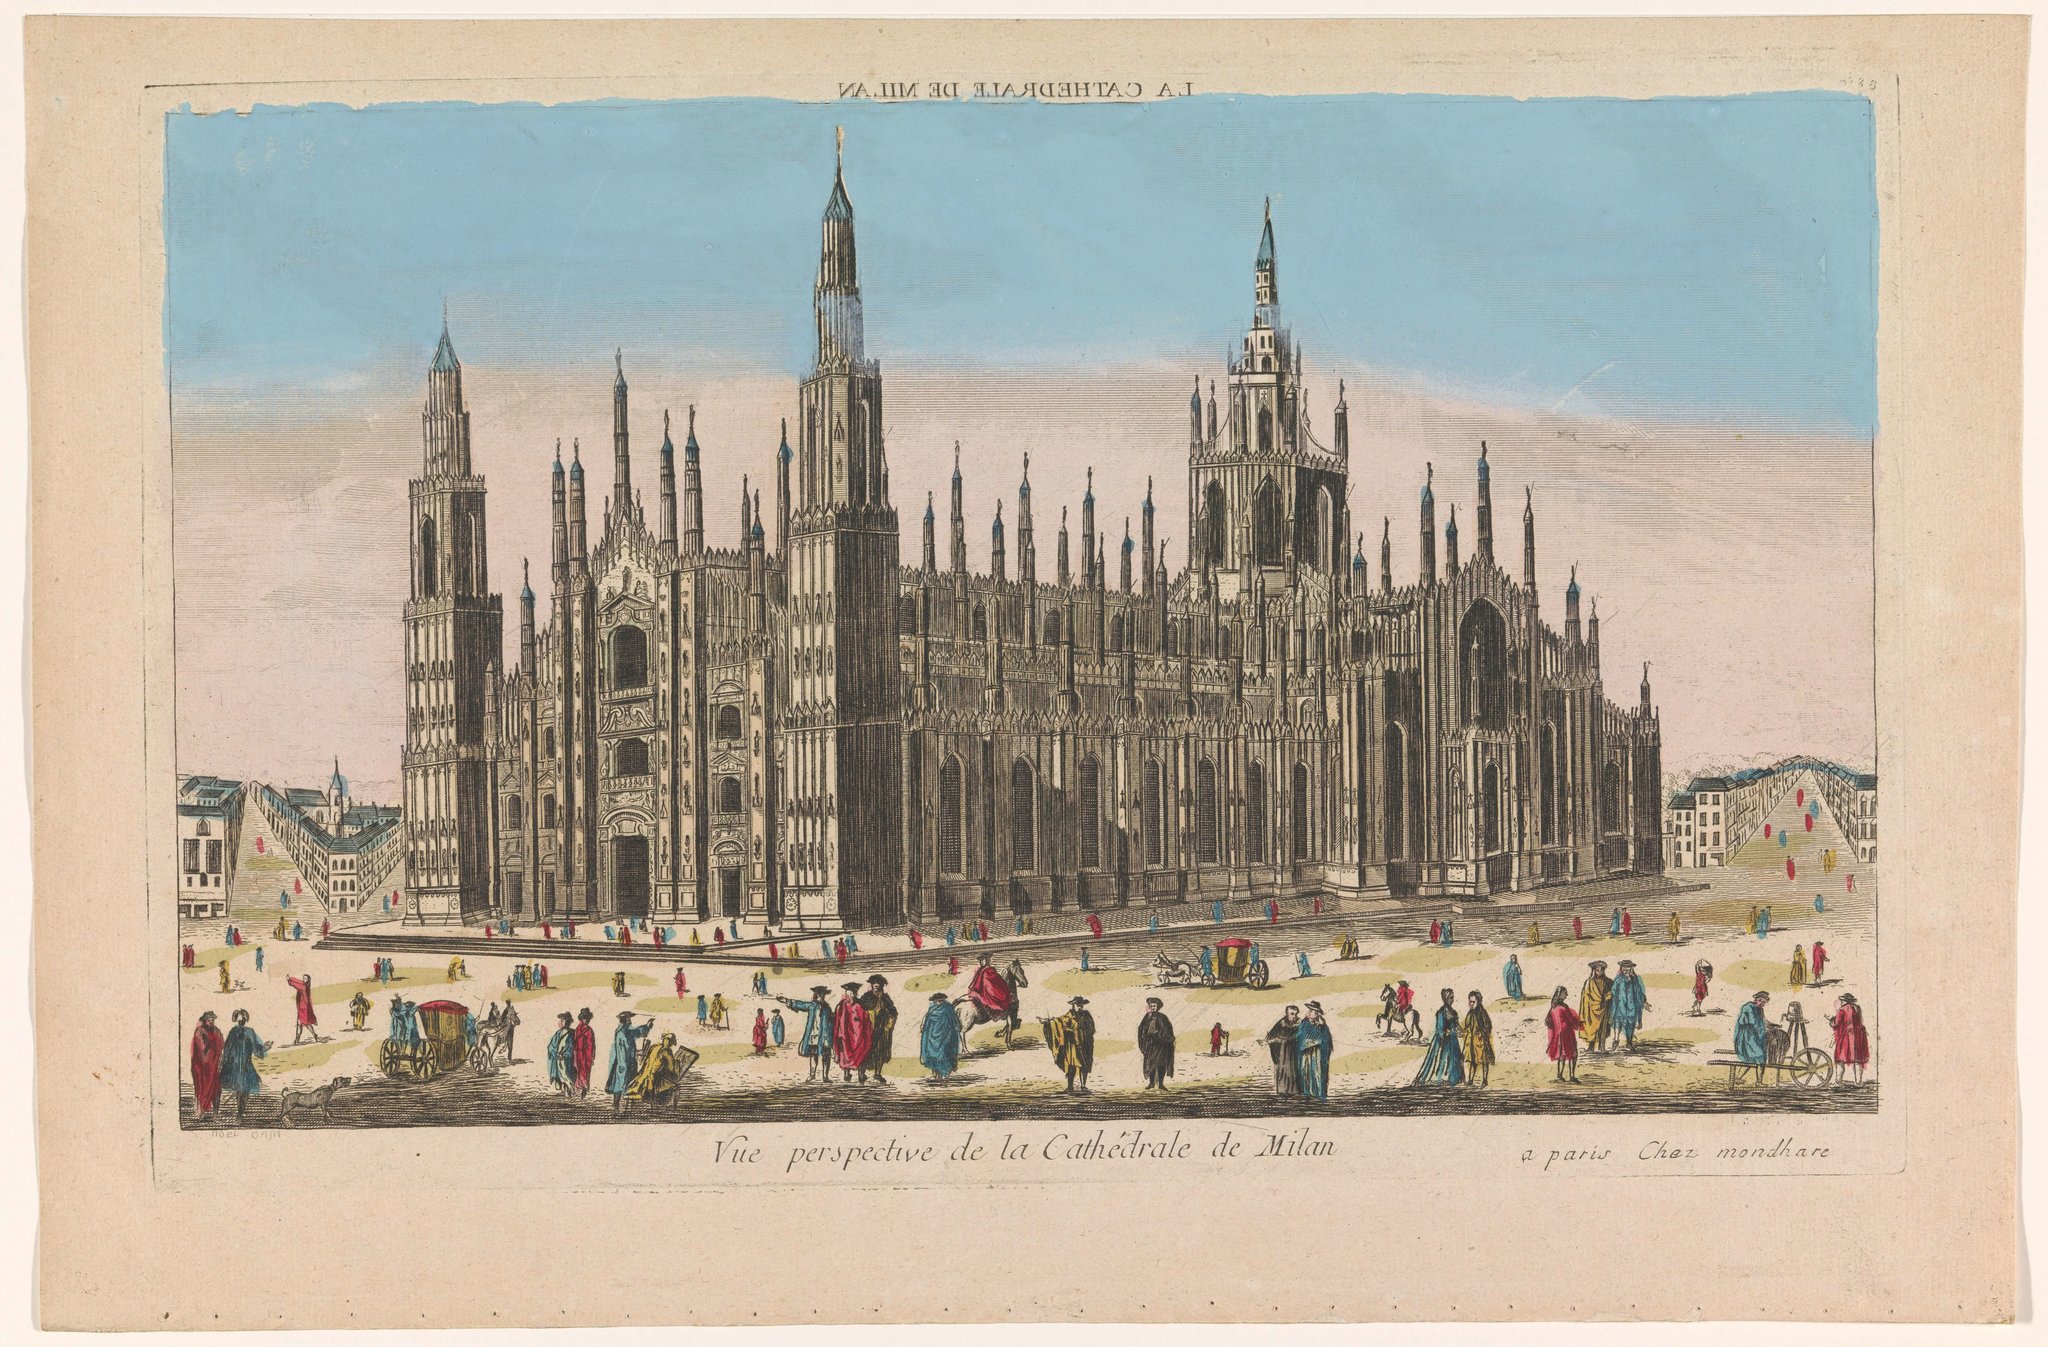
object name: print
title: Gezicht op de Dom te Milaan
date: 1759-1796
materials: paper, watercolor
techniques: brush, etching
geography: france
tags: church (exterior), square, place, circus, etc. (+ city(-scape) with figures, staffage), street (+ city(-scape) with figures, staffage)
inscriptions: collector's mark: Lugt 2166, watermark